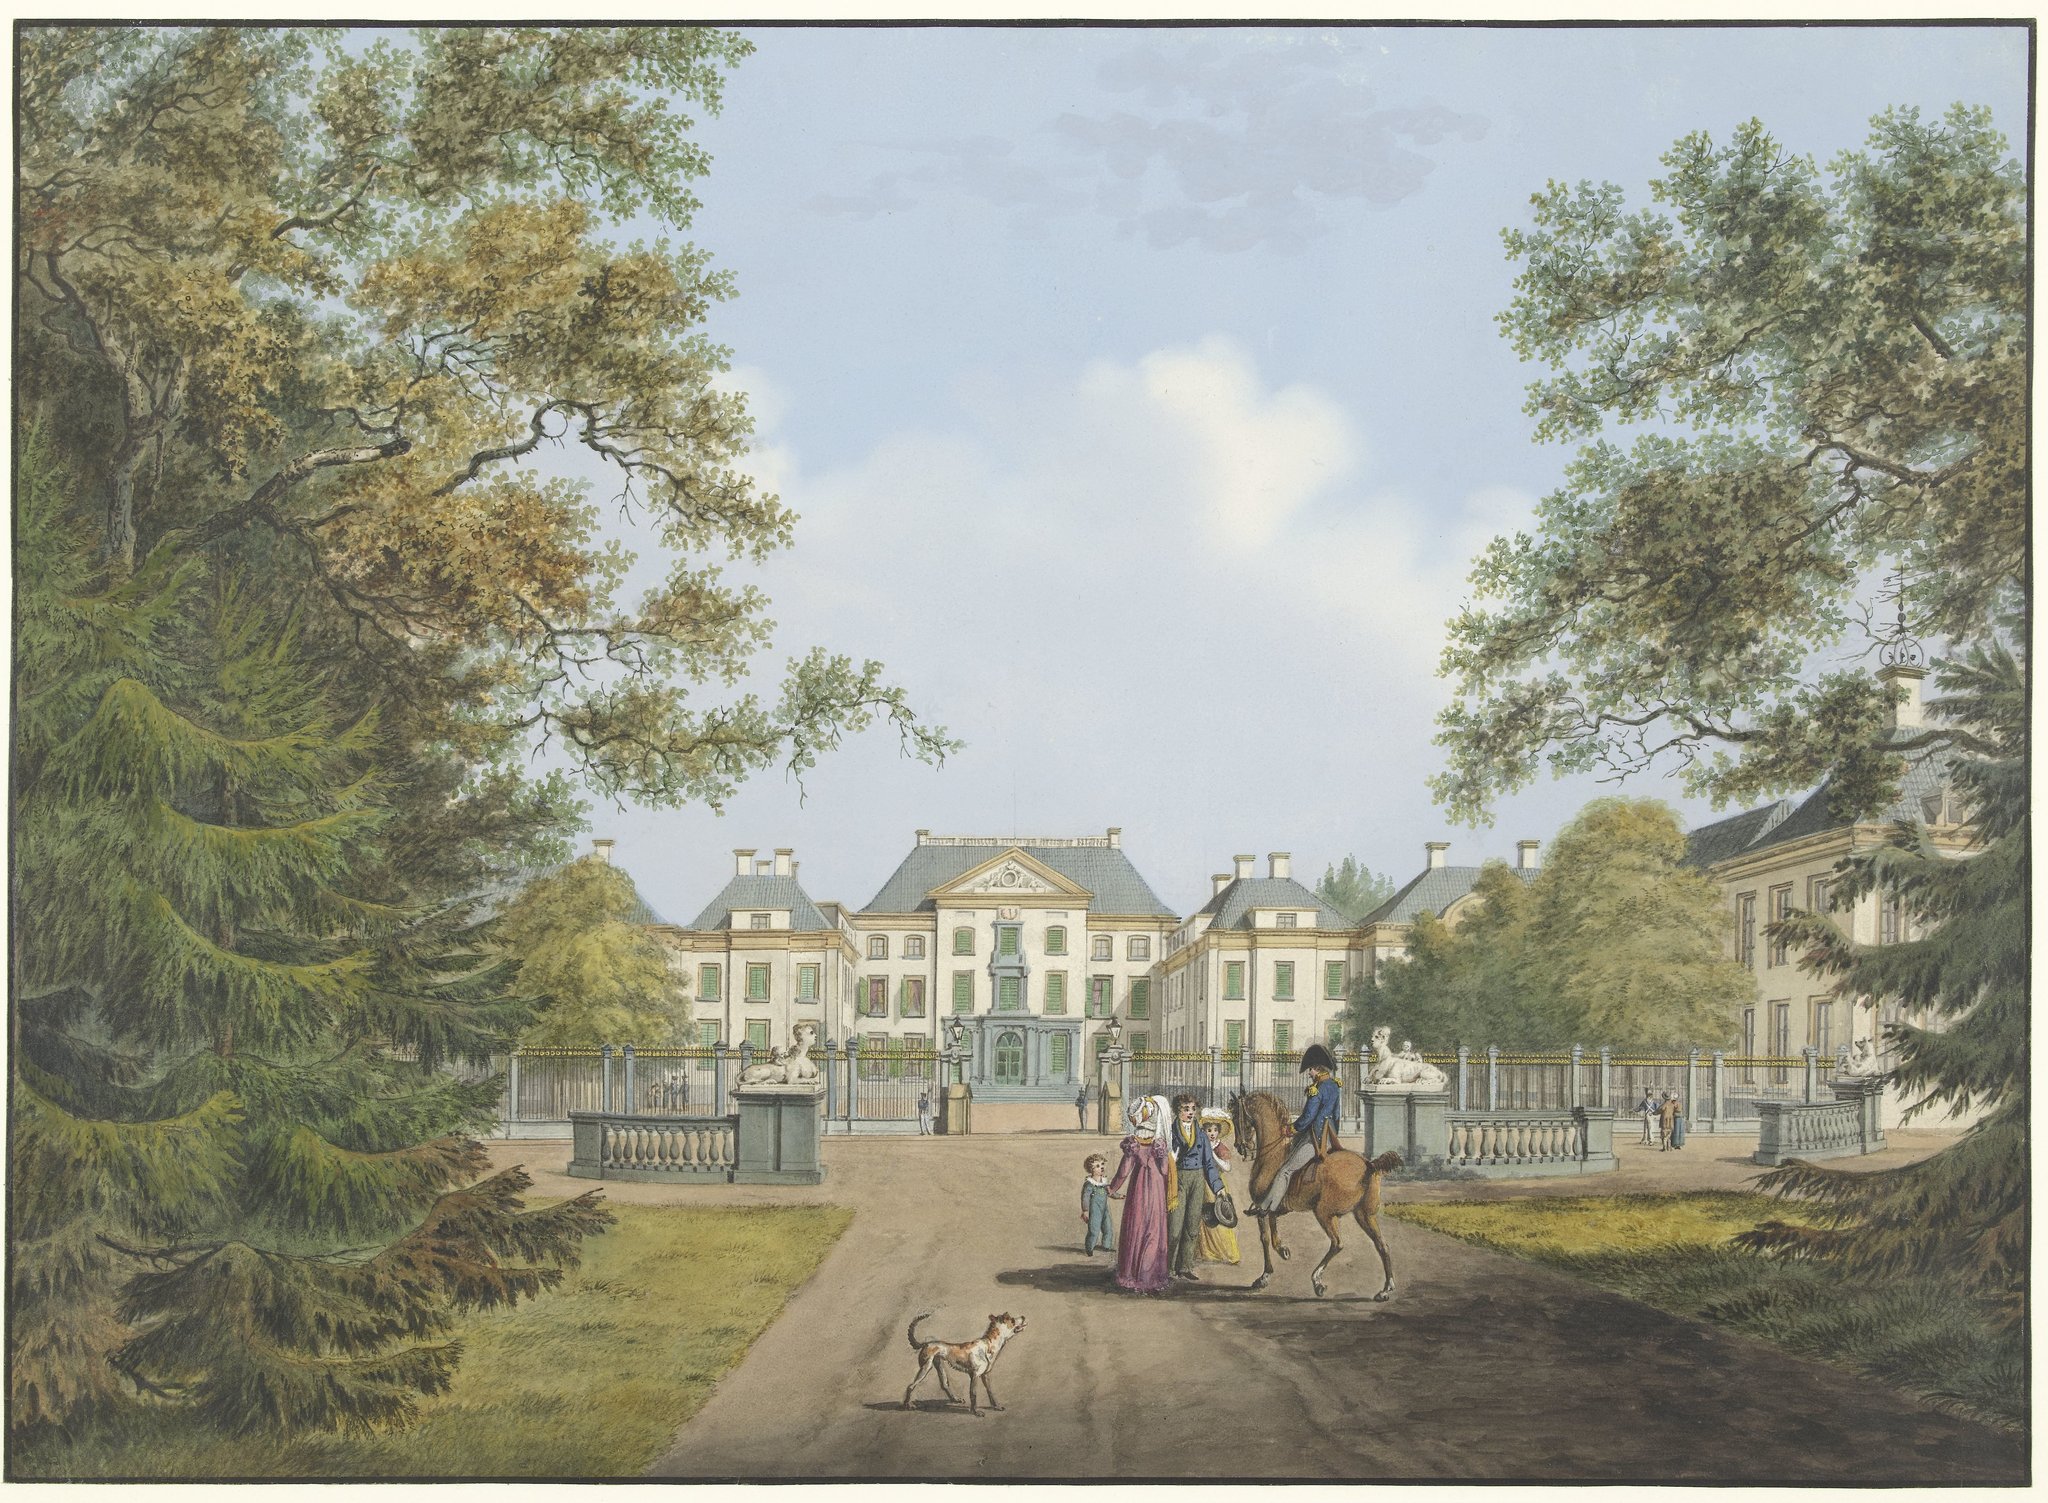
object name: watercolor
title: Gezicht op paleis Het Loo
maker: cornelis de kruyff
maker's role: draughtsman, print maker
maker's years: 1774-1828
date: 1784-1828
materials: chalk, ink, paper, watercolor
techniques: brush, pen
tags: palace